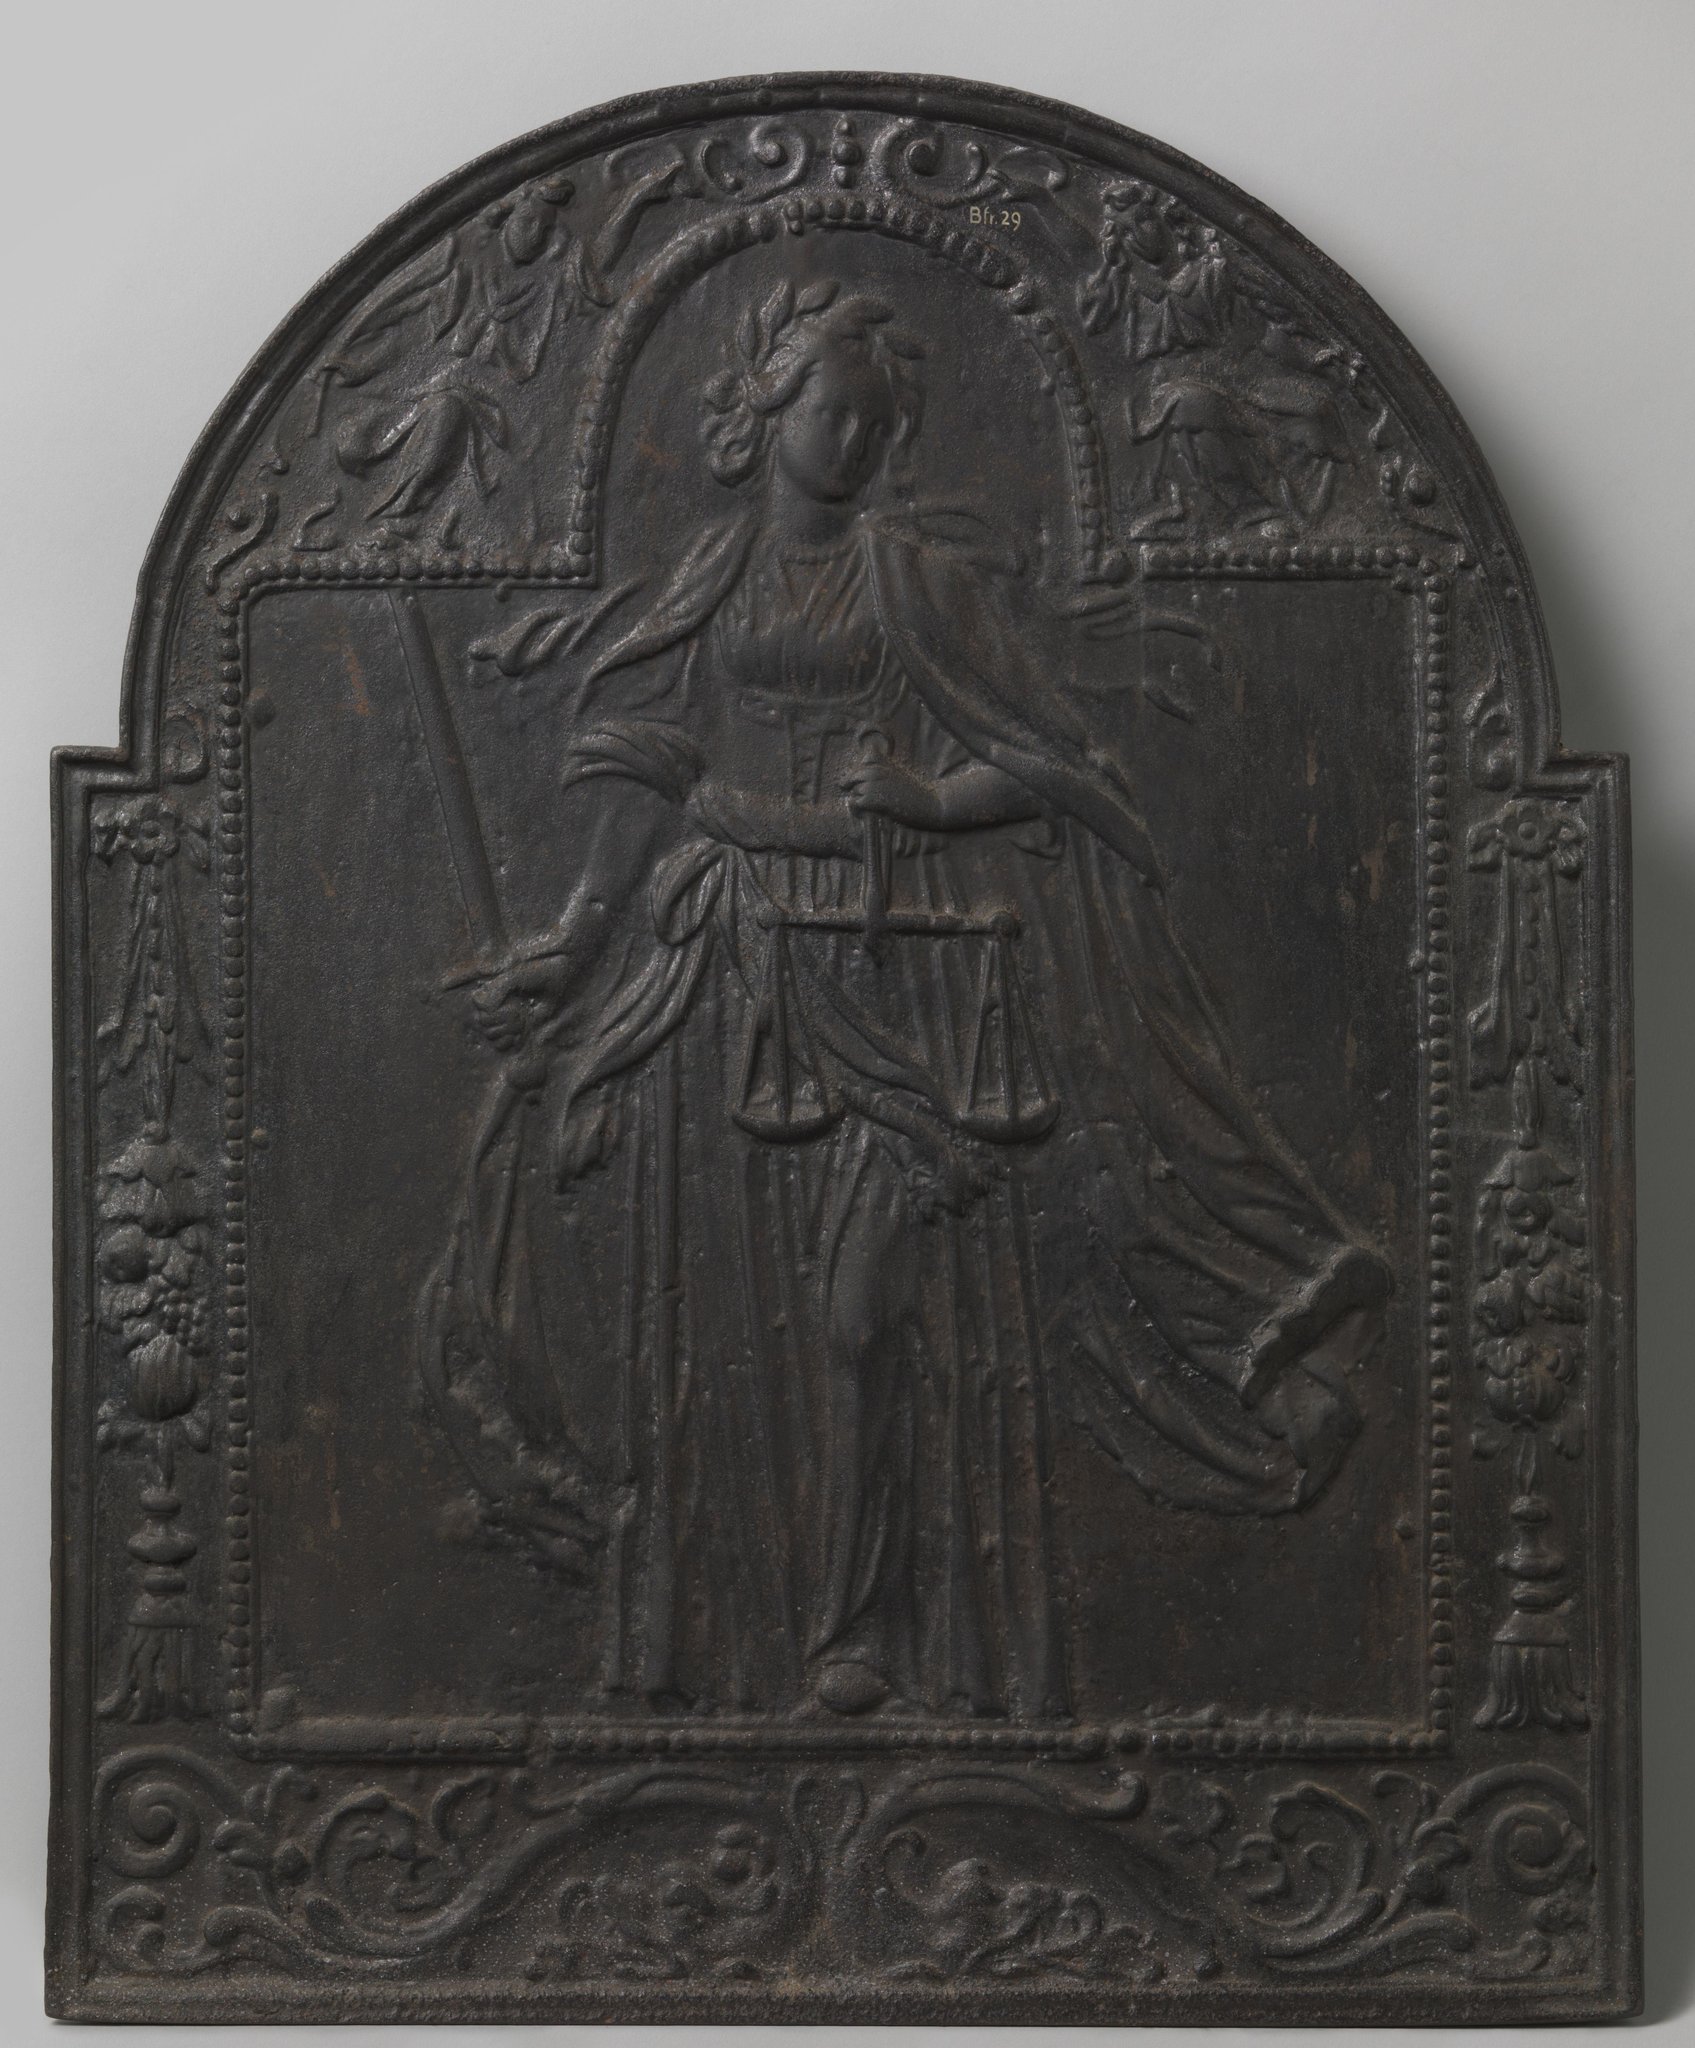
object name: fireback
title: Haardplaat met Justitia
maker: Anonymous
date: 1650-1700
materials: iron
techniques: casting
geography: germany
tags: justice, 'justitia'; 'giustitia divina' (ripa) ~ one of the four cardinal virtues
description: Haardplaat van gietijzer, met een halfronde bovenzijde. Centraal de personificatie van Justitia (Gerechtigheid) met een zwaard en weegschaal in haar handen. Het geheel is omlijst met een rand, versierd met festoenen aan de zijkanten en rankmotieven aan de onderzijde. Aan weerszijden van het hoofd van Justitia is in de rand een engel geplaatst.